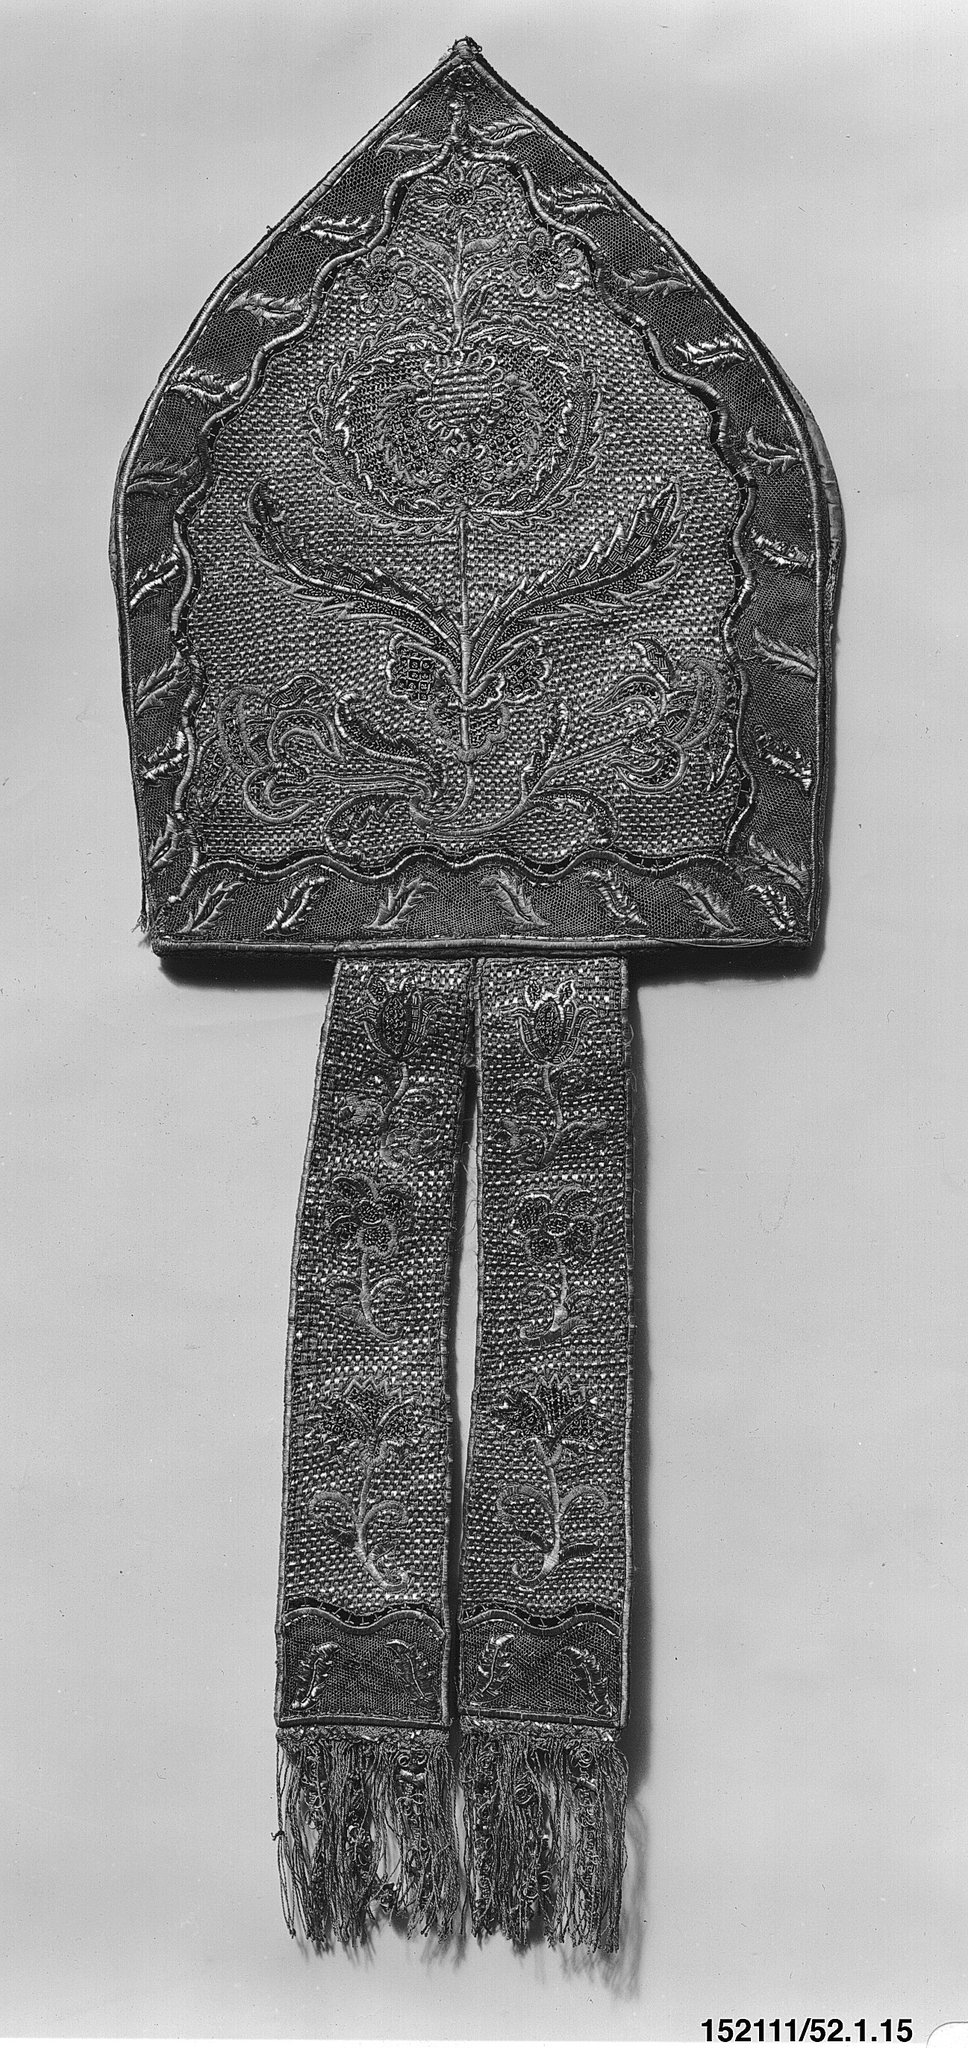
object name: mitre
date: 1767-1833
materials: metal thread, velvet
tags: flowers